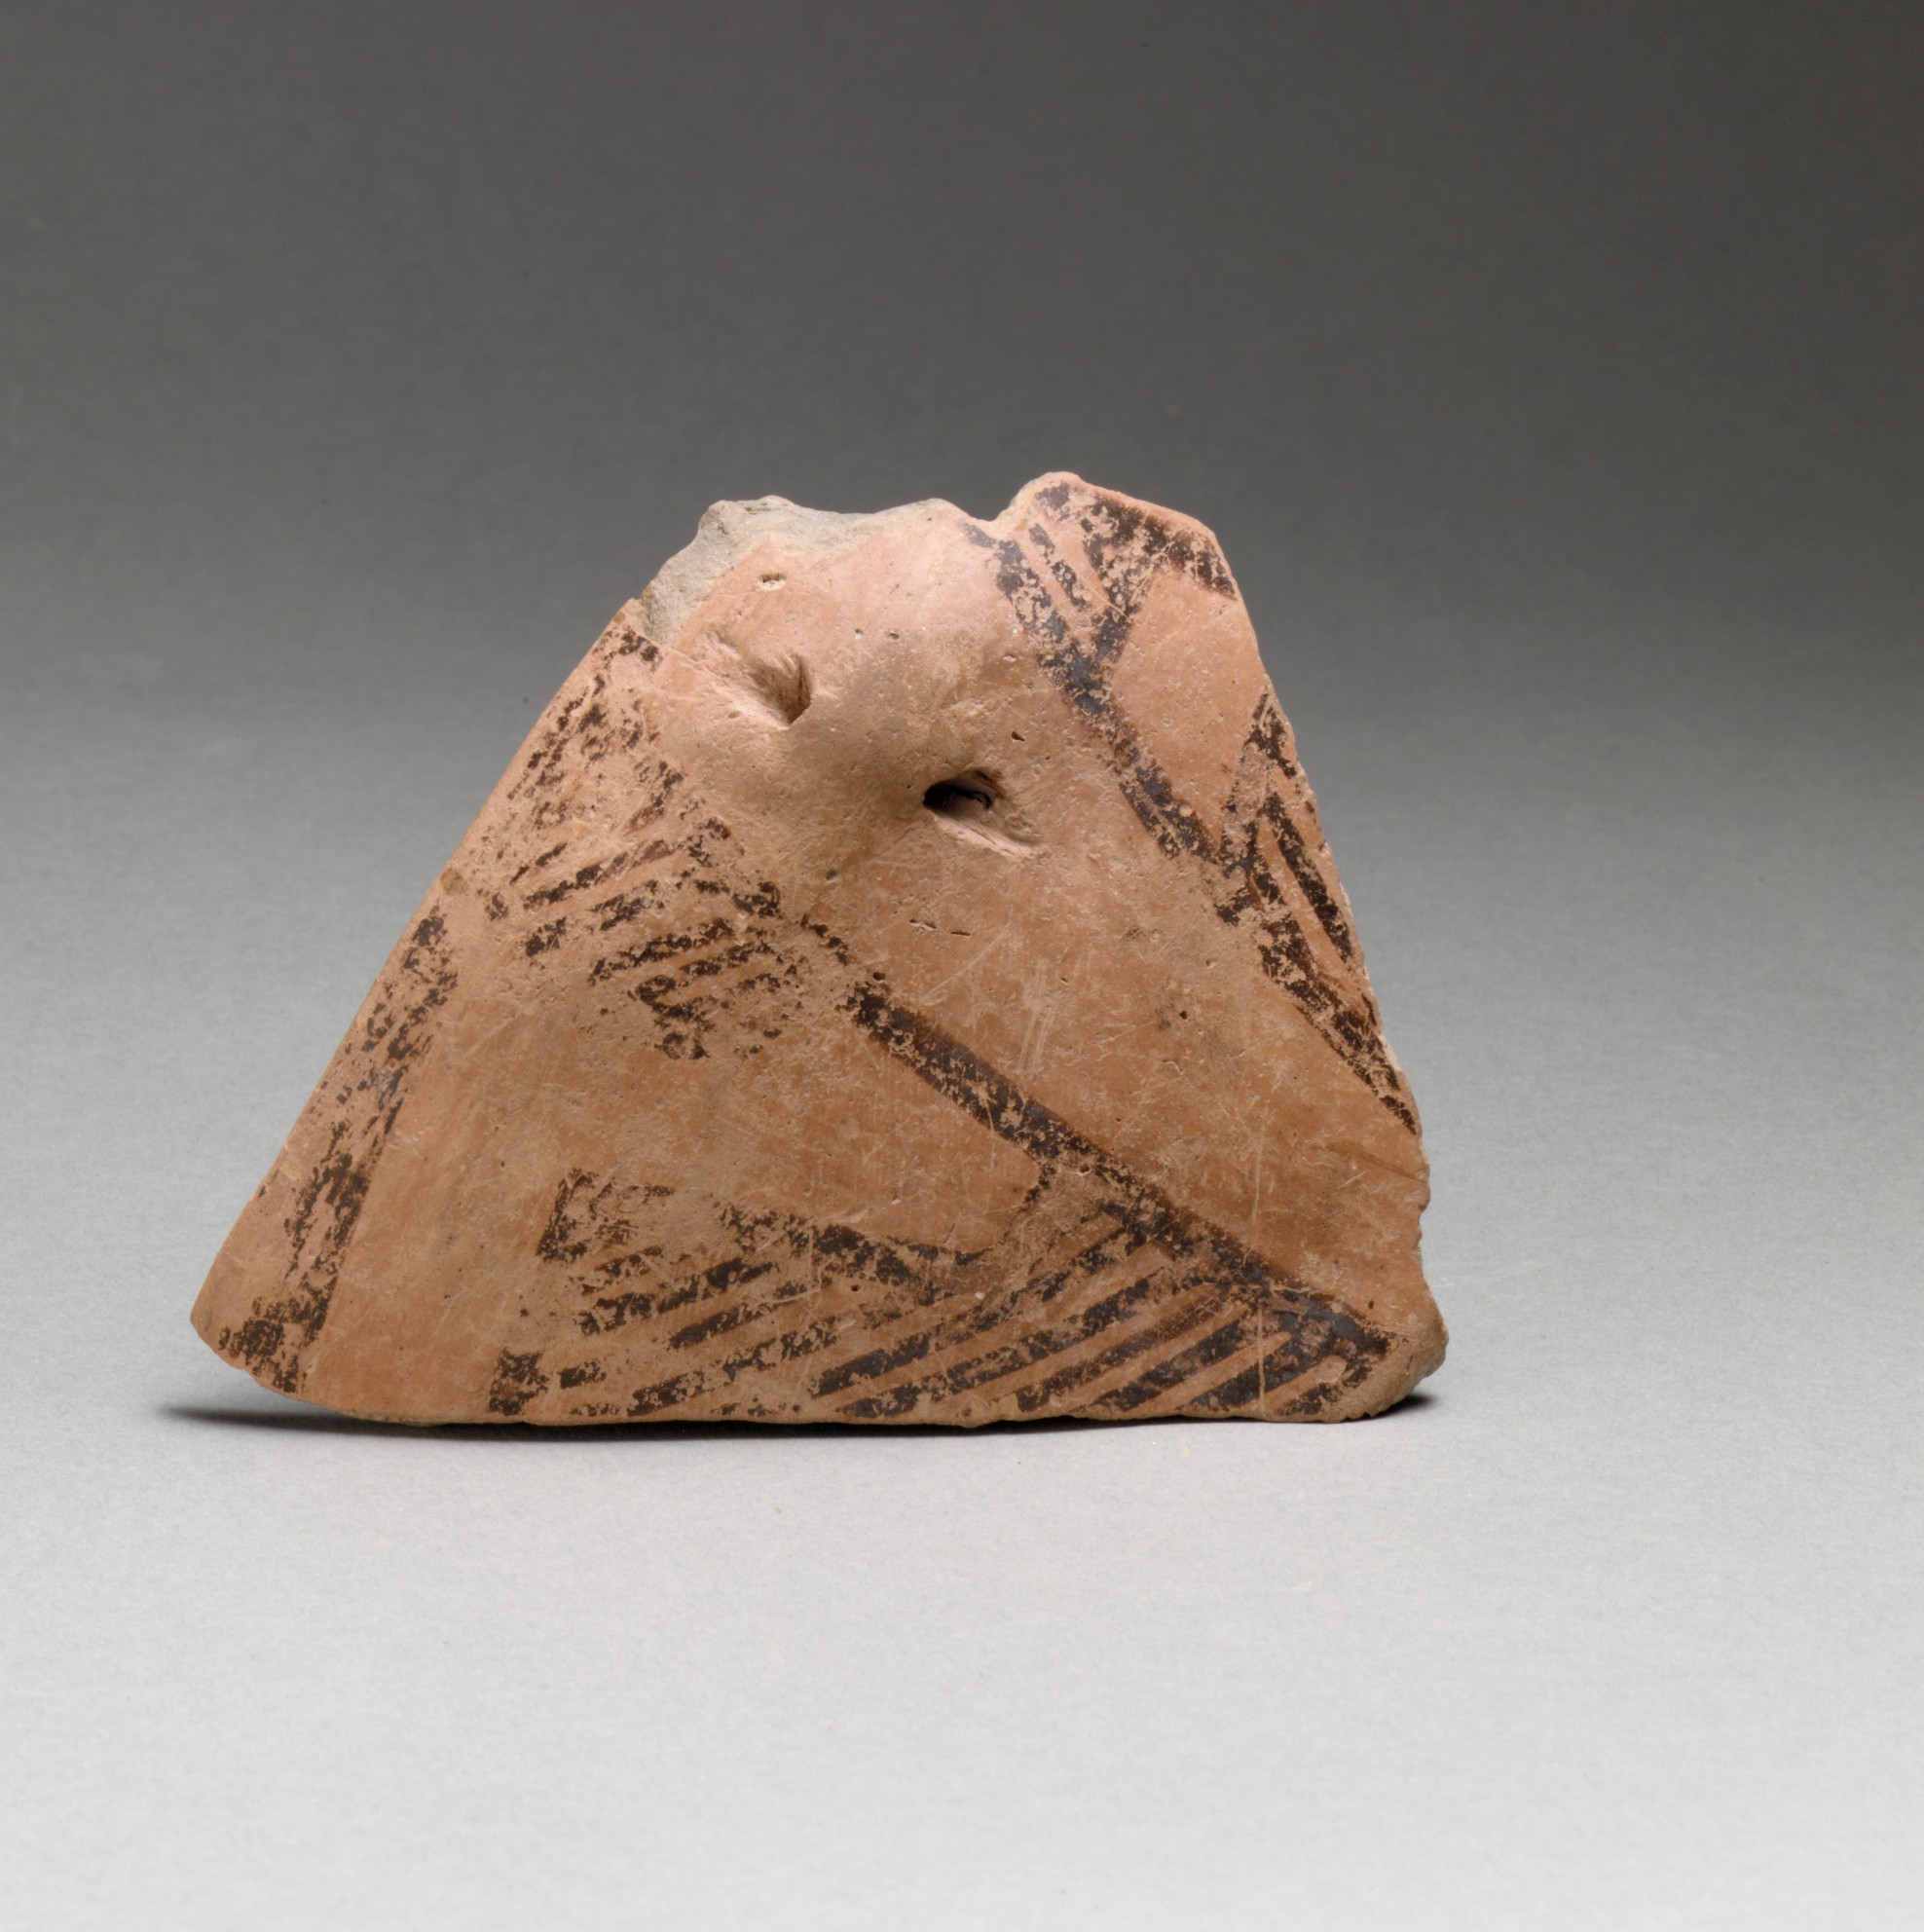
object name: vase fragment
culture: neolithic, thessaly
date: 4000-3000 BCE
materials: terracotta